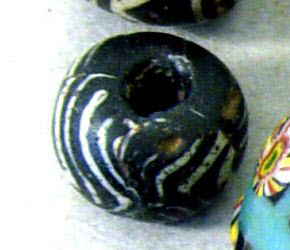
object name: bead, string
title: String of Beads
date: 801-1200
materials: glass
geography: egypt